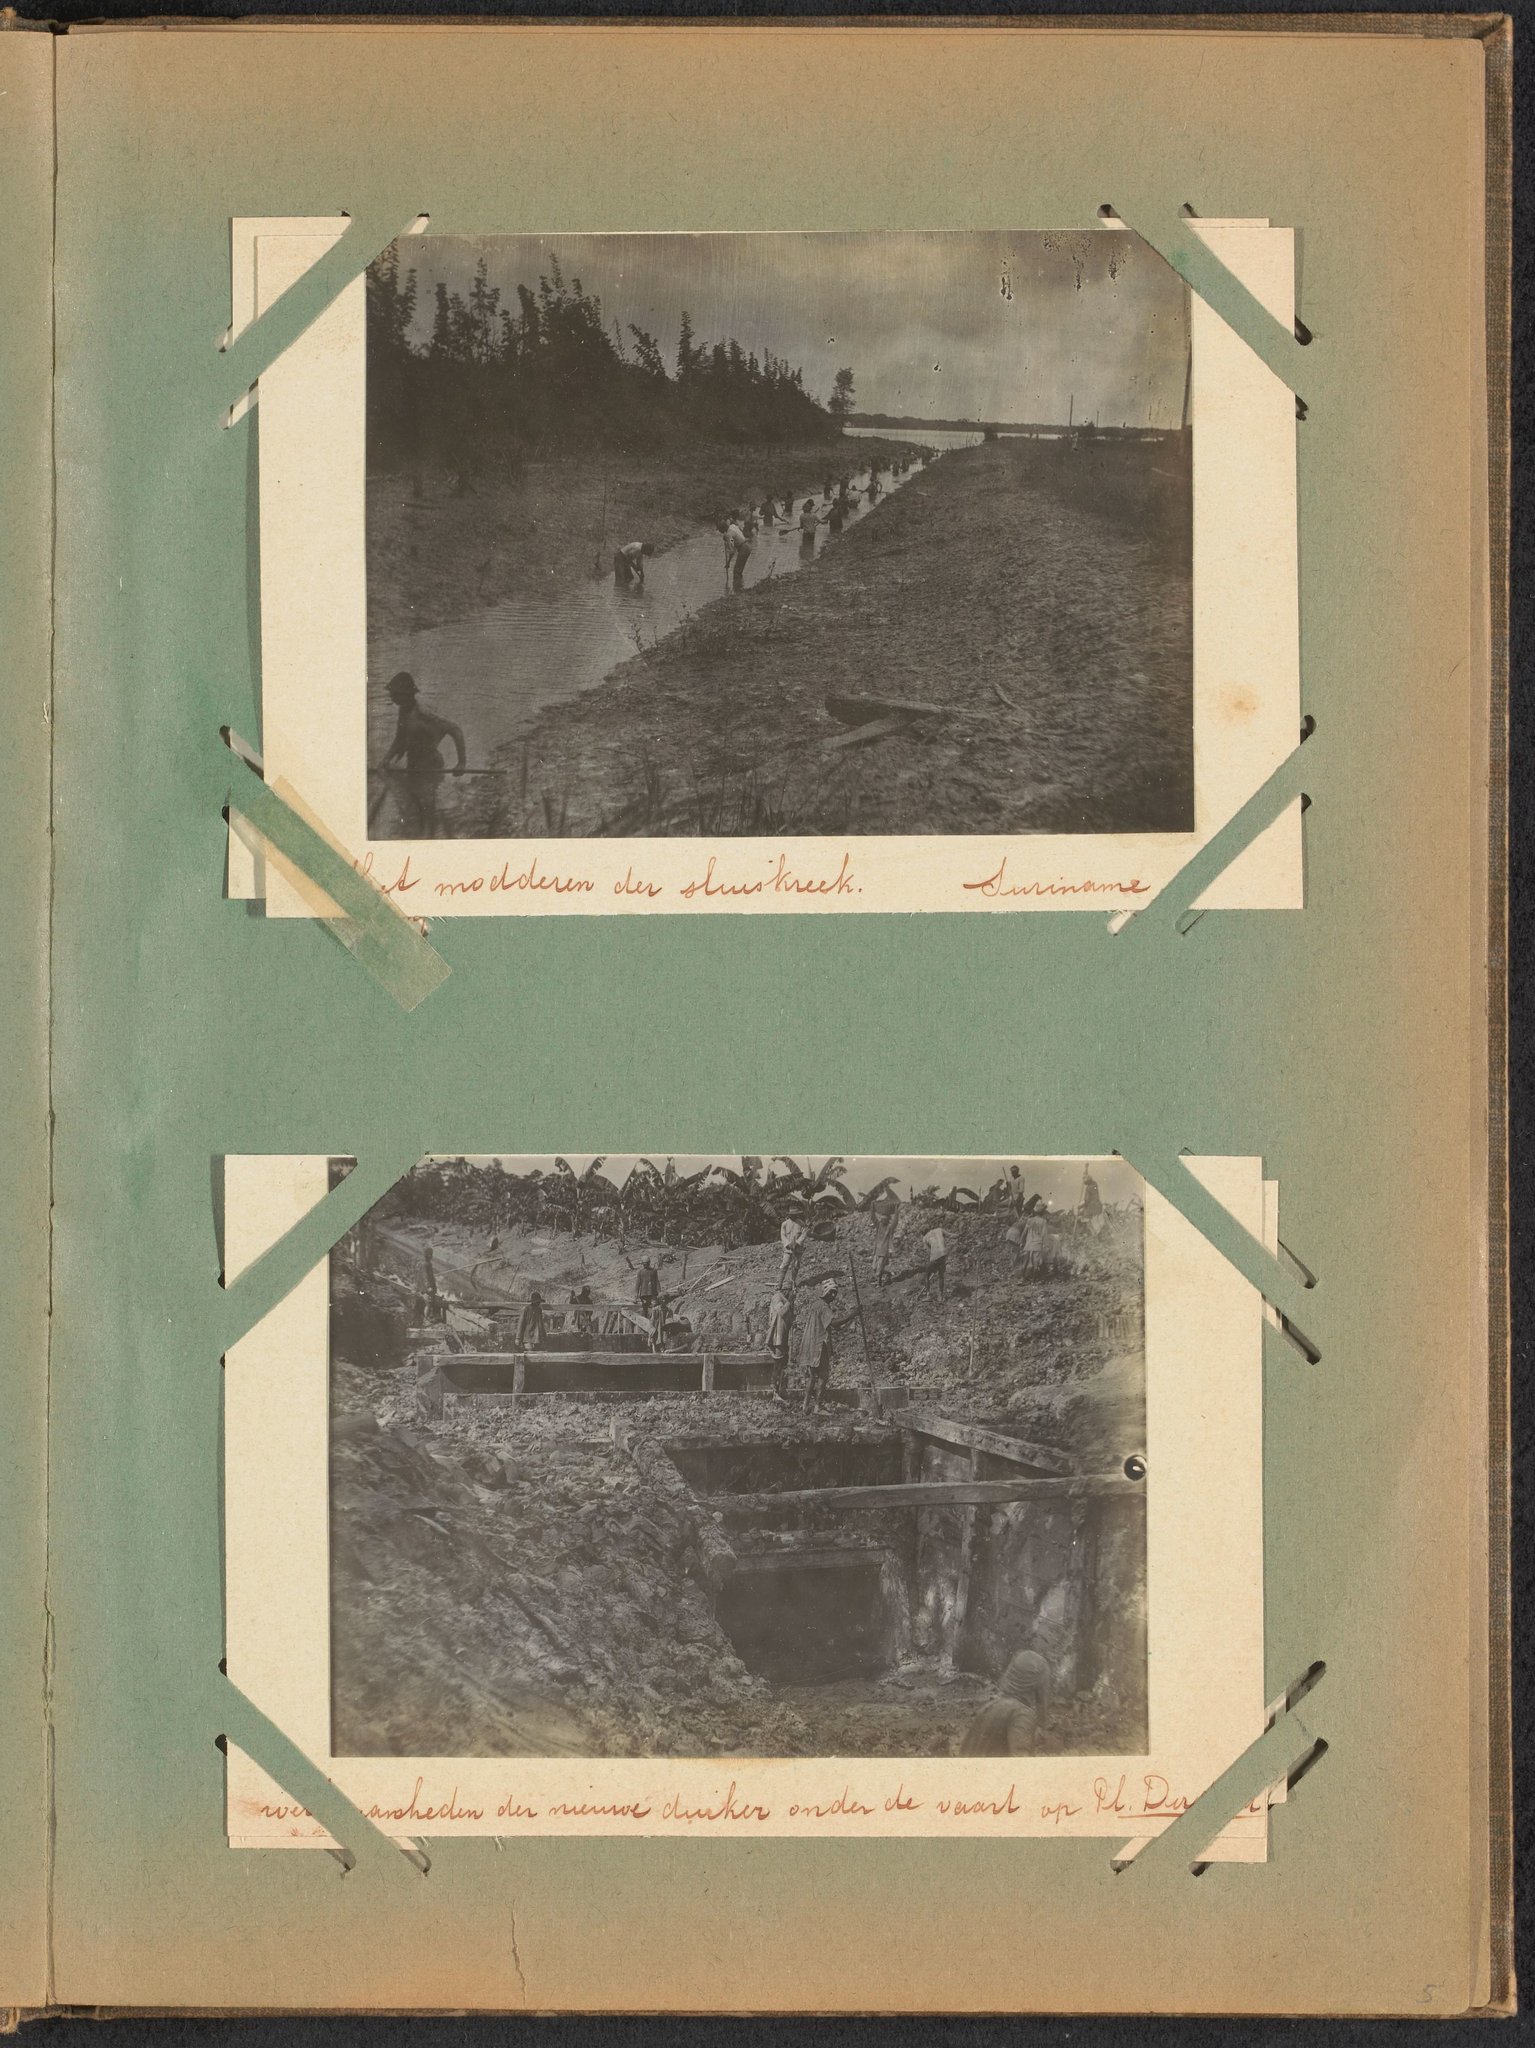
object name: photograph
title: werkzaamheden der nieuwe duiker onder de vaart op Pl. Dordrecht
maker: Anonymous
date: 1912-1913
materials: paper, photographic support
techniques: gelatin silver print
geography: suriname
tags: plantation, suriname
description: Graafwerkzaamheden op Plantage Dordrecht in Suriname. Onderdeel van het fotoalbum uit ca. 1912-1913 met 92 foto's van de plantages Peperpot en Dordrecht in Suriname en Mount Pleasant op Curaçao.